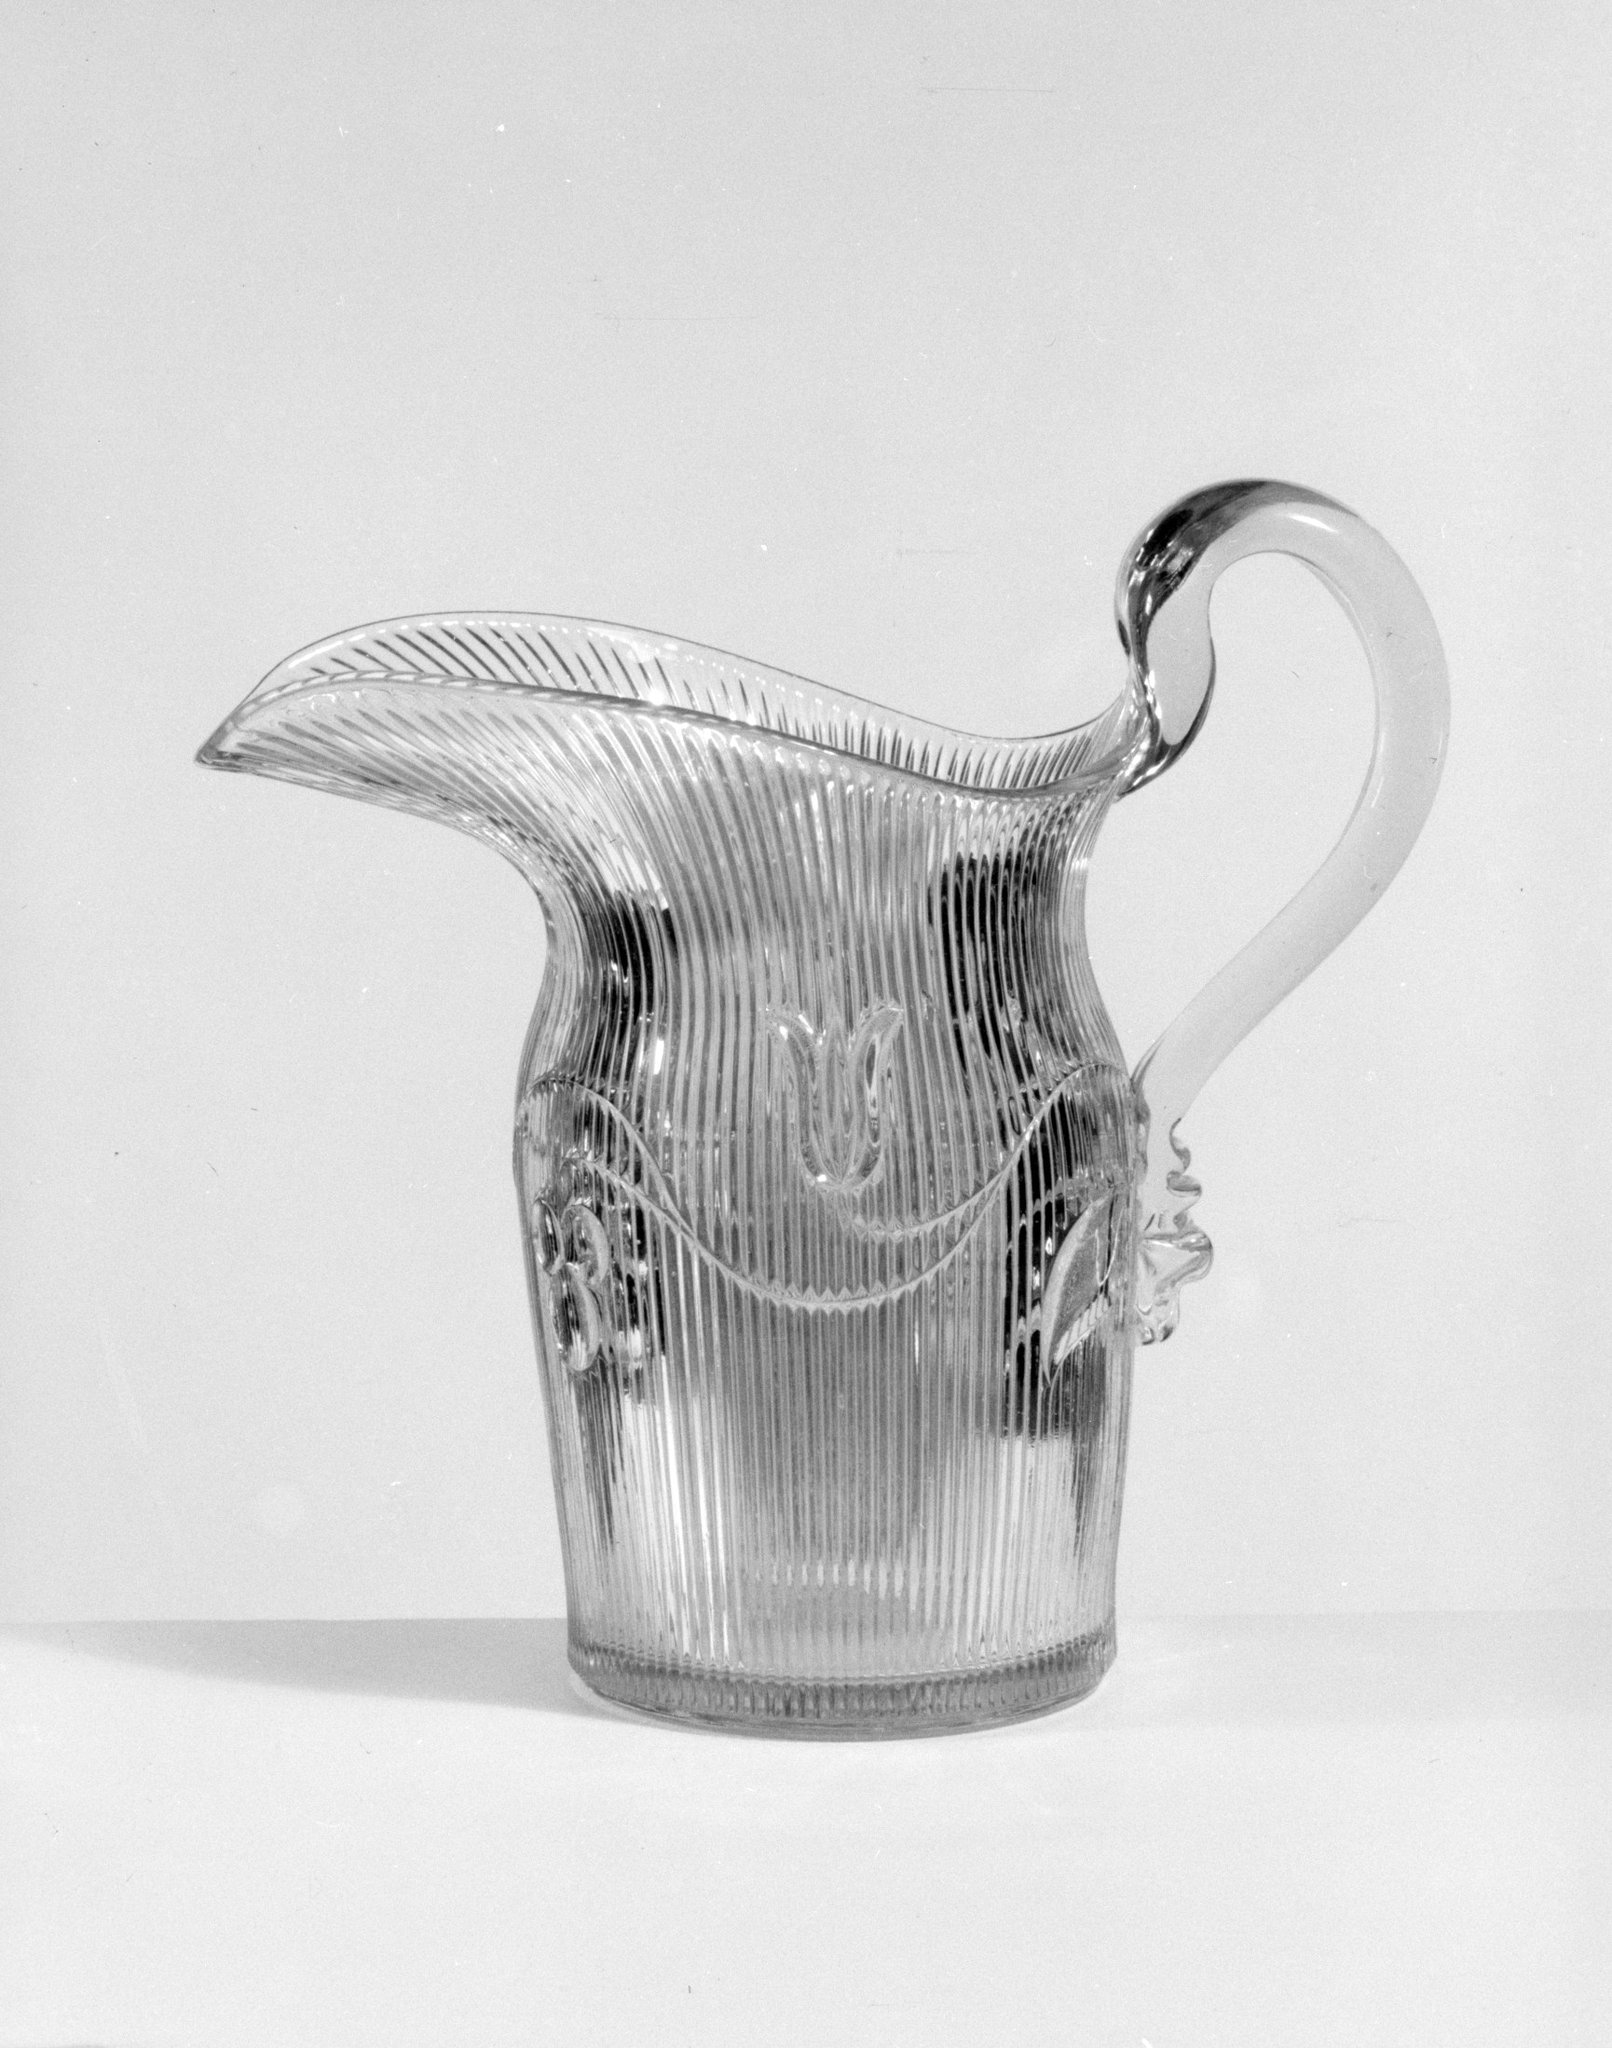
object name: pitcher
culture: american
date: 1850-1870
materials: glass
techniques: pressed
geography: united states